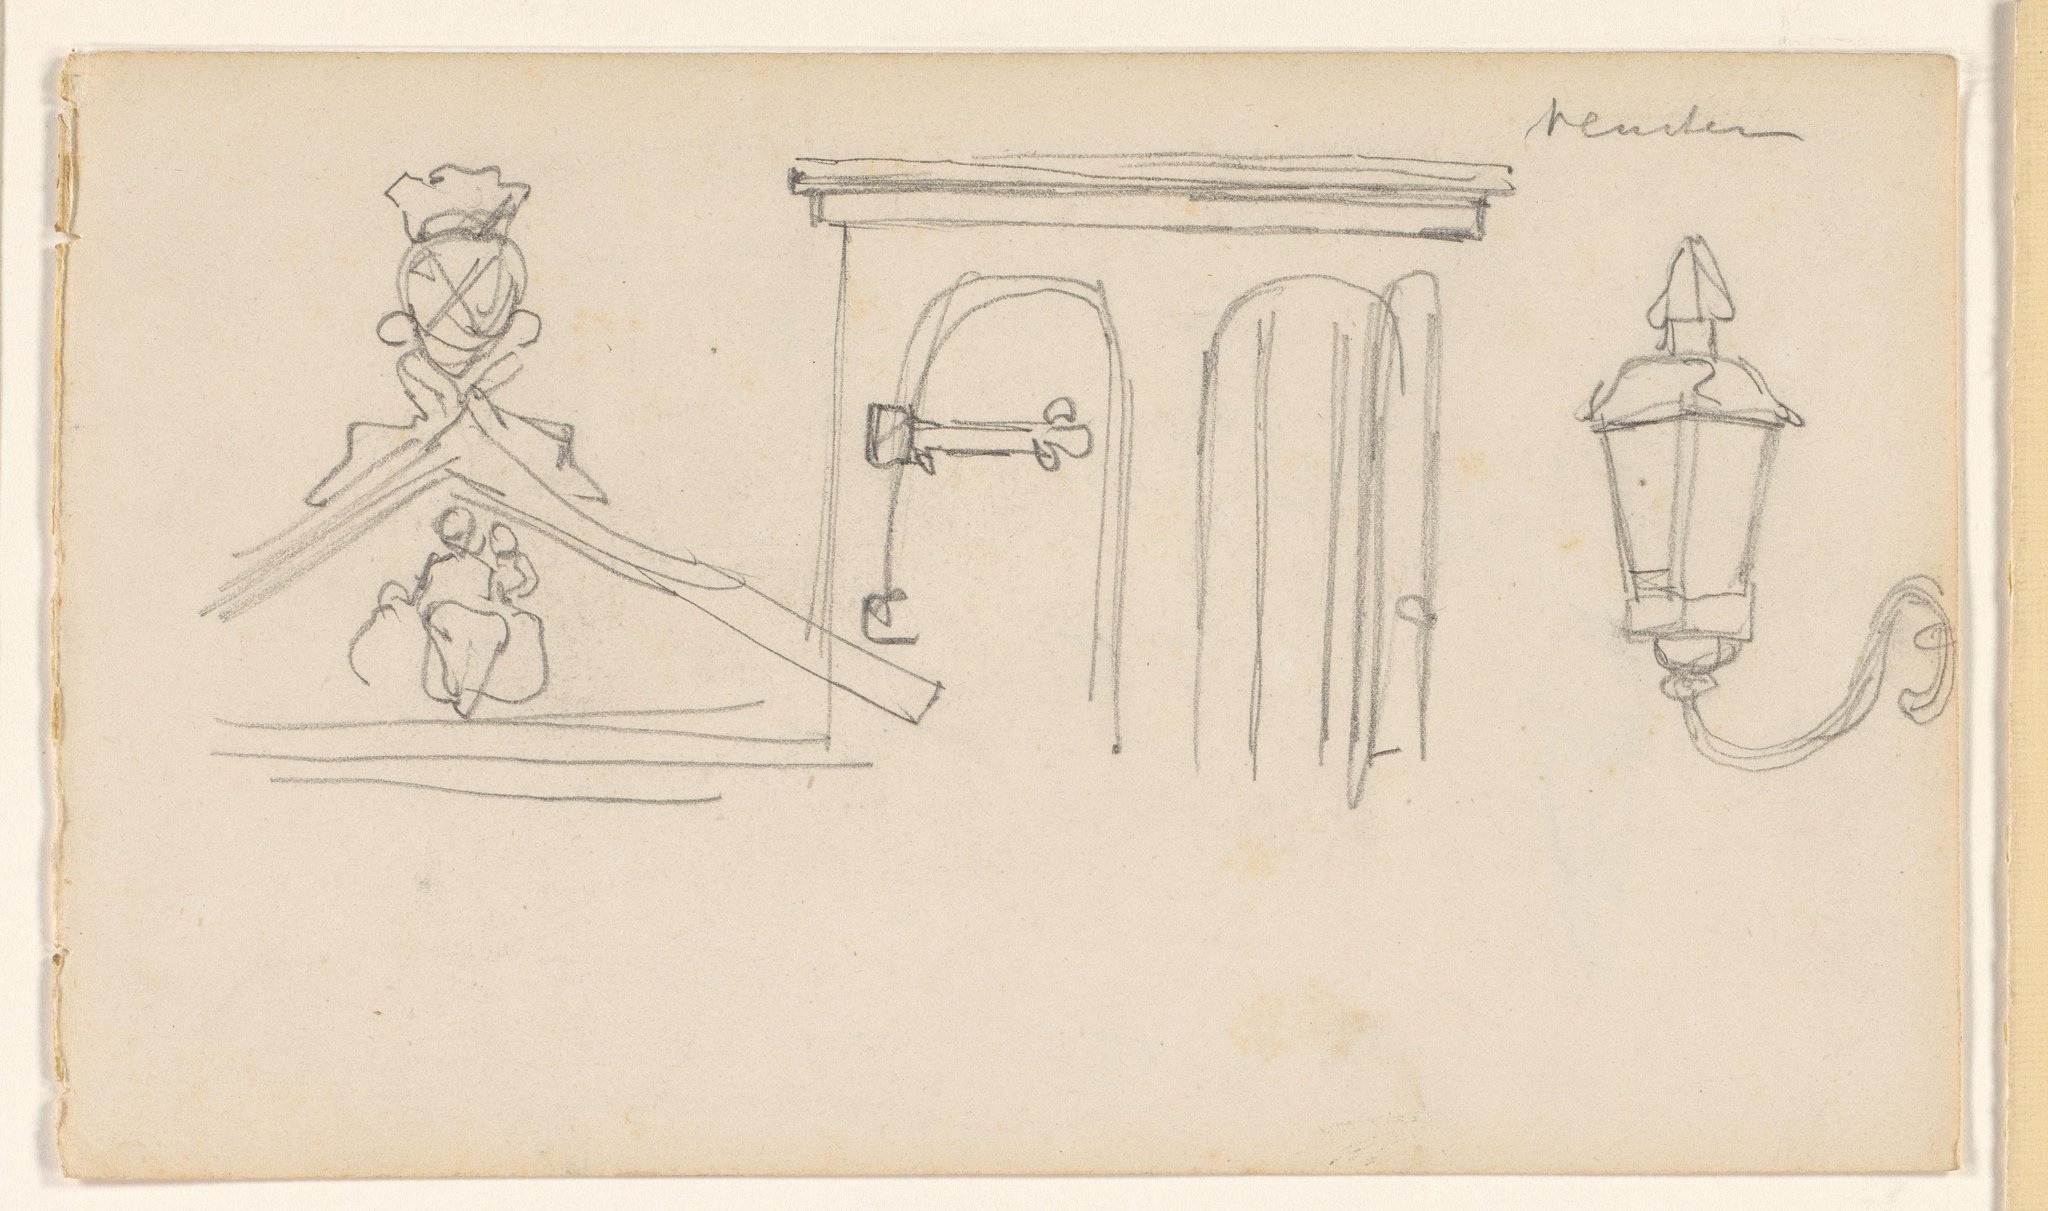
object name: drawing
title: Schetsblad met architectuurstudies, lamp, kast, gevel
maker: august allebé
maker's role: draughtsman, print maker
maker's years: 1838-1927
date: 1848-1927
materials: paper, pencil